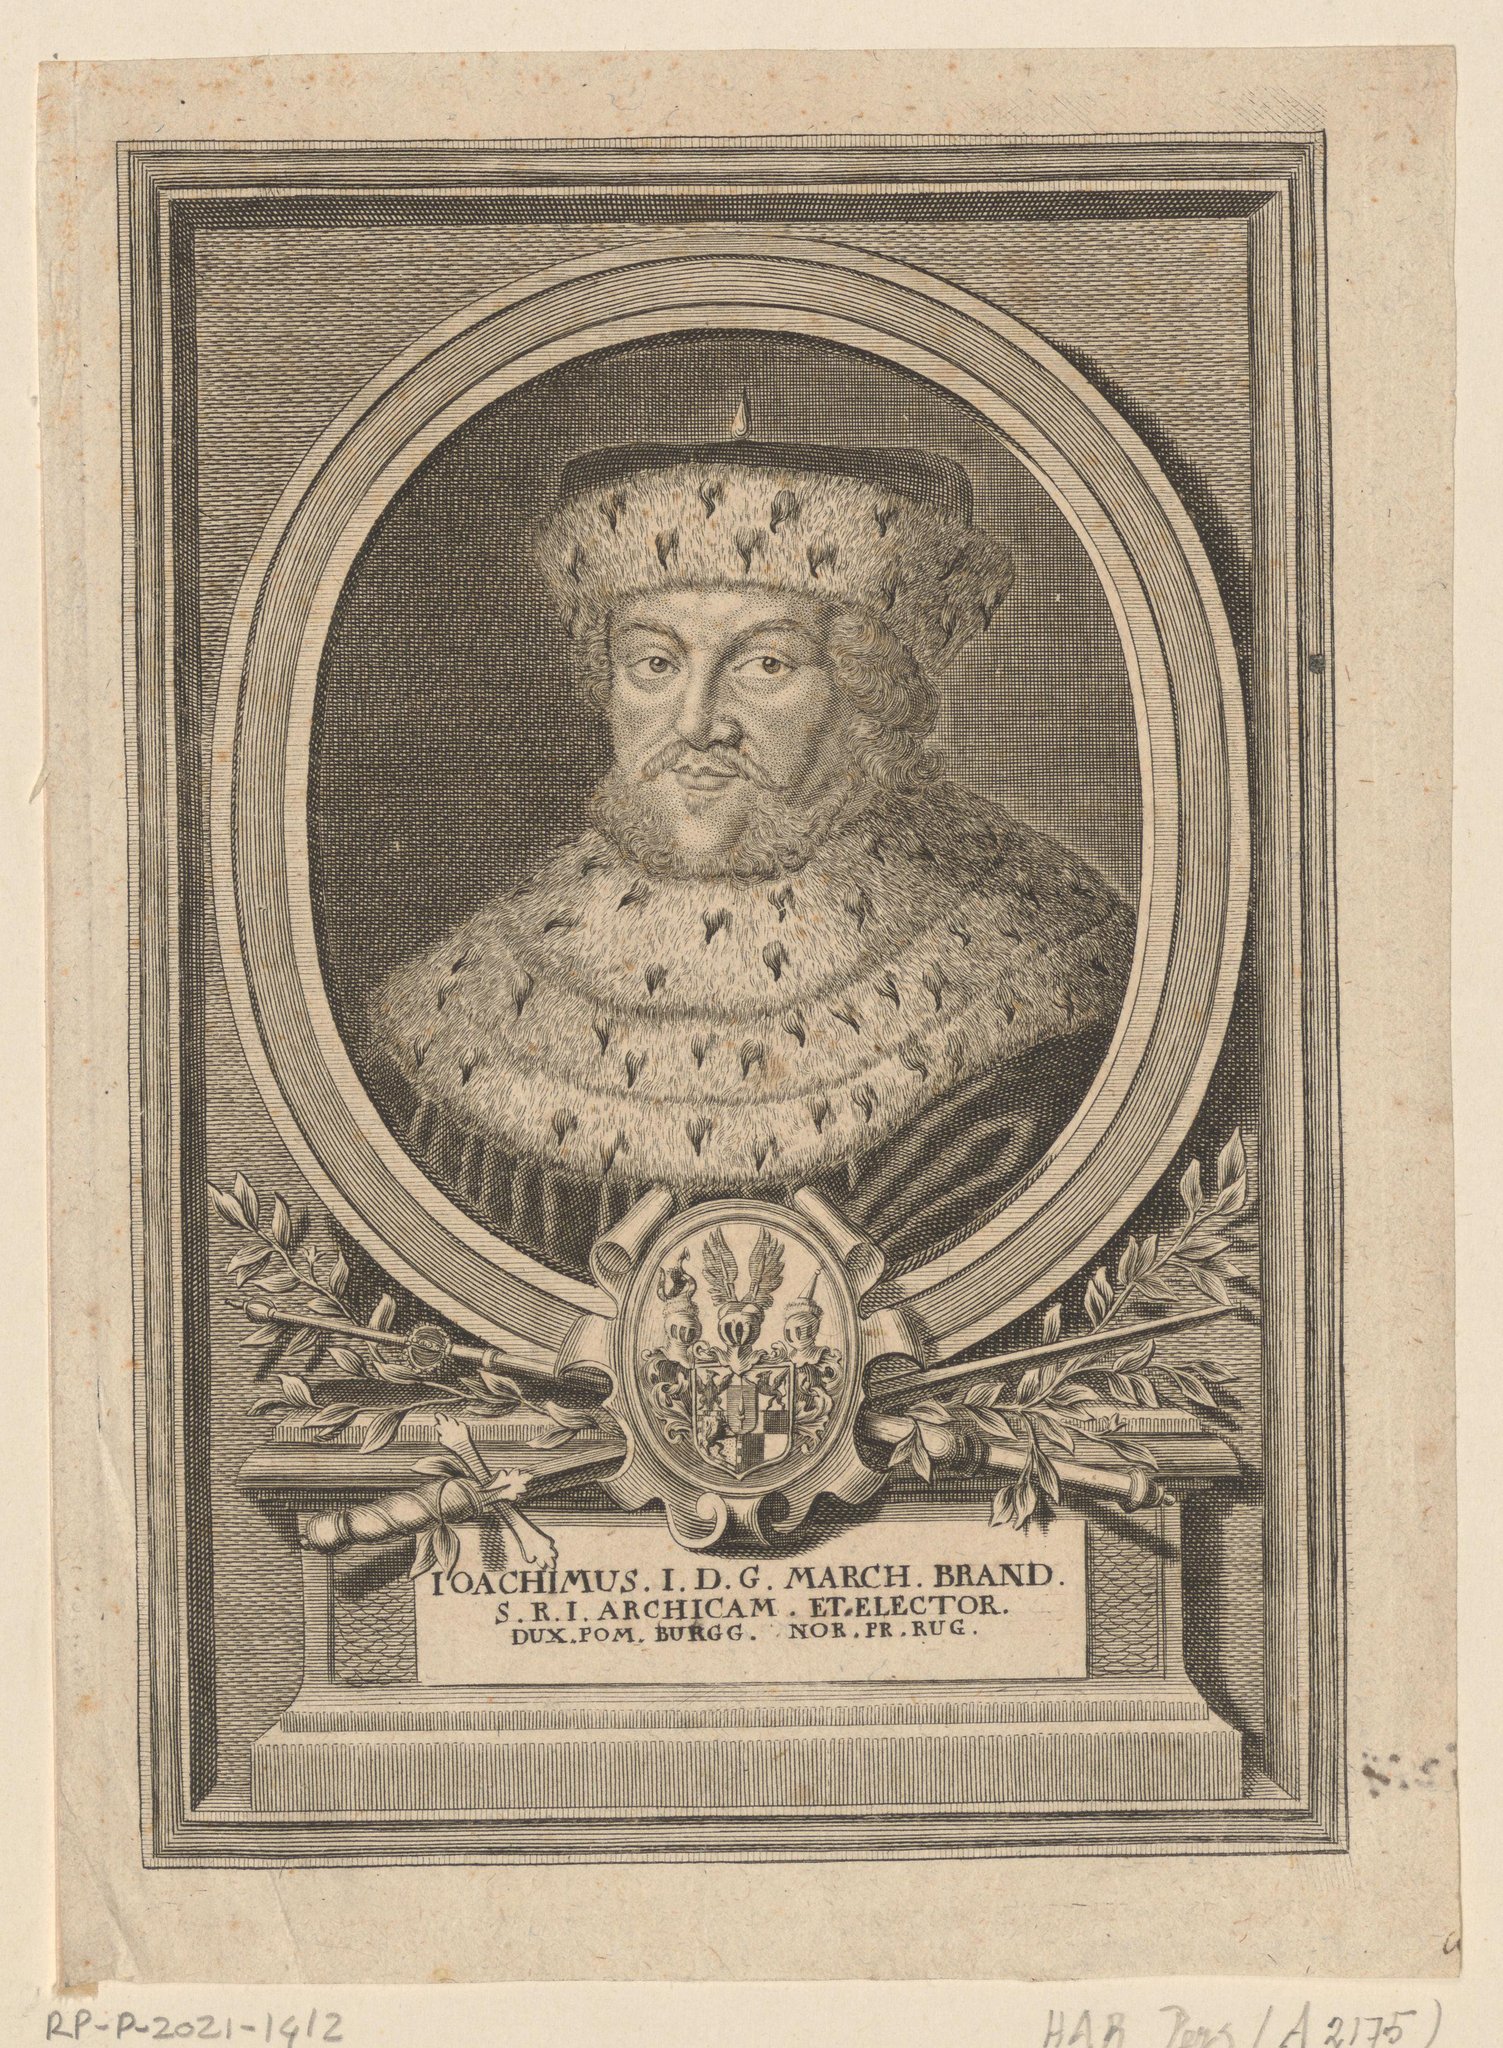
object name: print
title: Portret van Joachim I Nestor van Brandenburg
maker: Anonymous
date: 1728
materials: paper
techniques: engraving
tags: berlin, historical persons, ruler, sovereign, armorial bearing, heraldry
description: Prent mogelijk uit: Tapfferkeit des märkischen Adels oder das vor Joachimo I zu Brandenburg (...). Frankfurt en Leipzig: s.n., 1728.